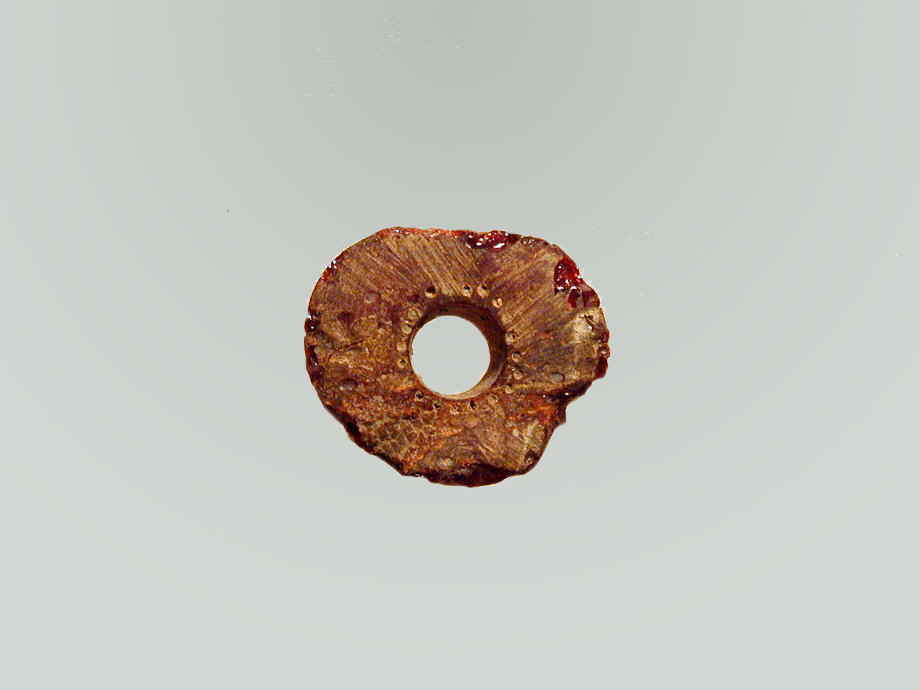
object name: fibula, fragment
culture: etruscan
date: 700-501 BCE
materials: amber